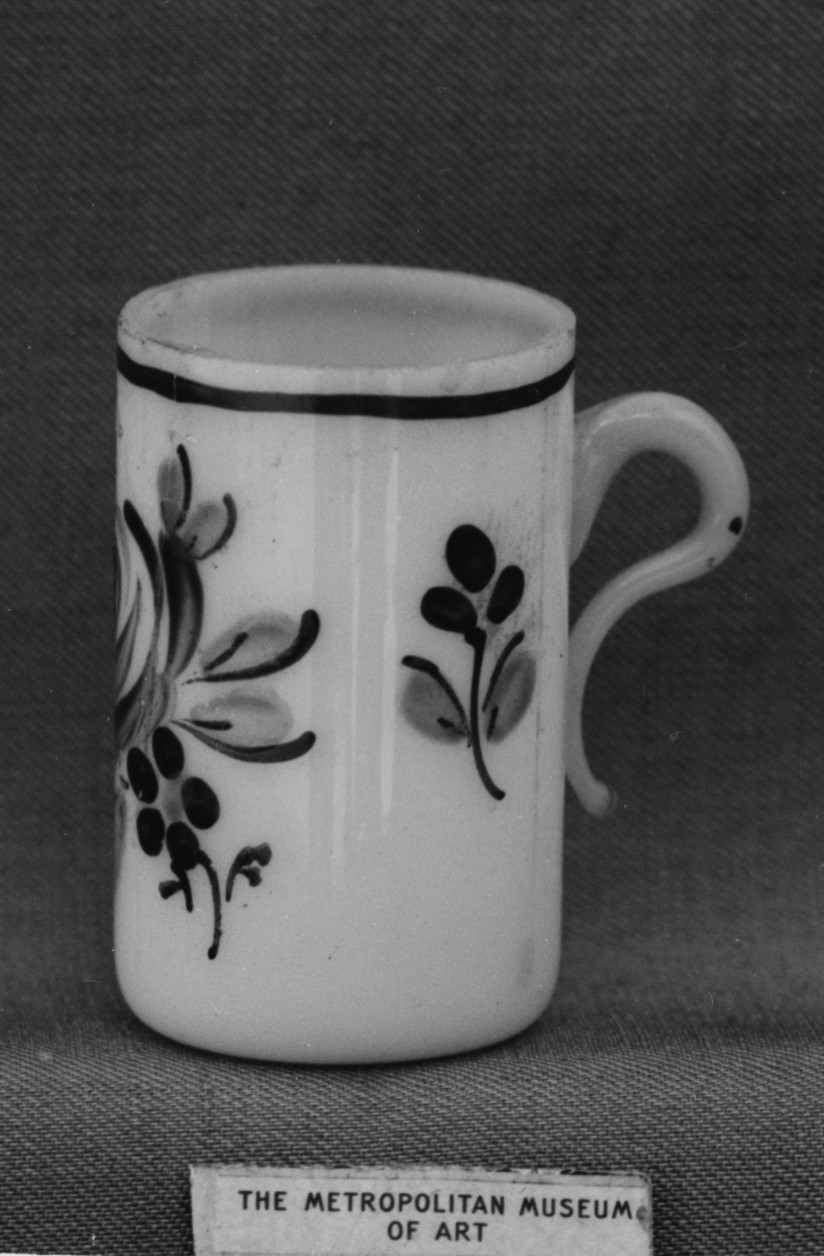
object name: mug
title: Miniature mug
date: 1701-1900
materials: glass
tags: flowers